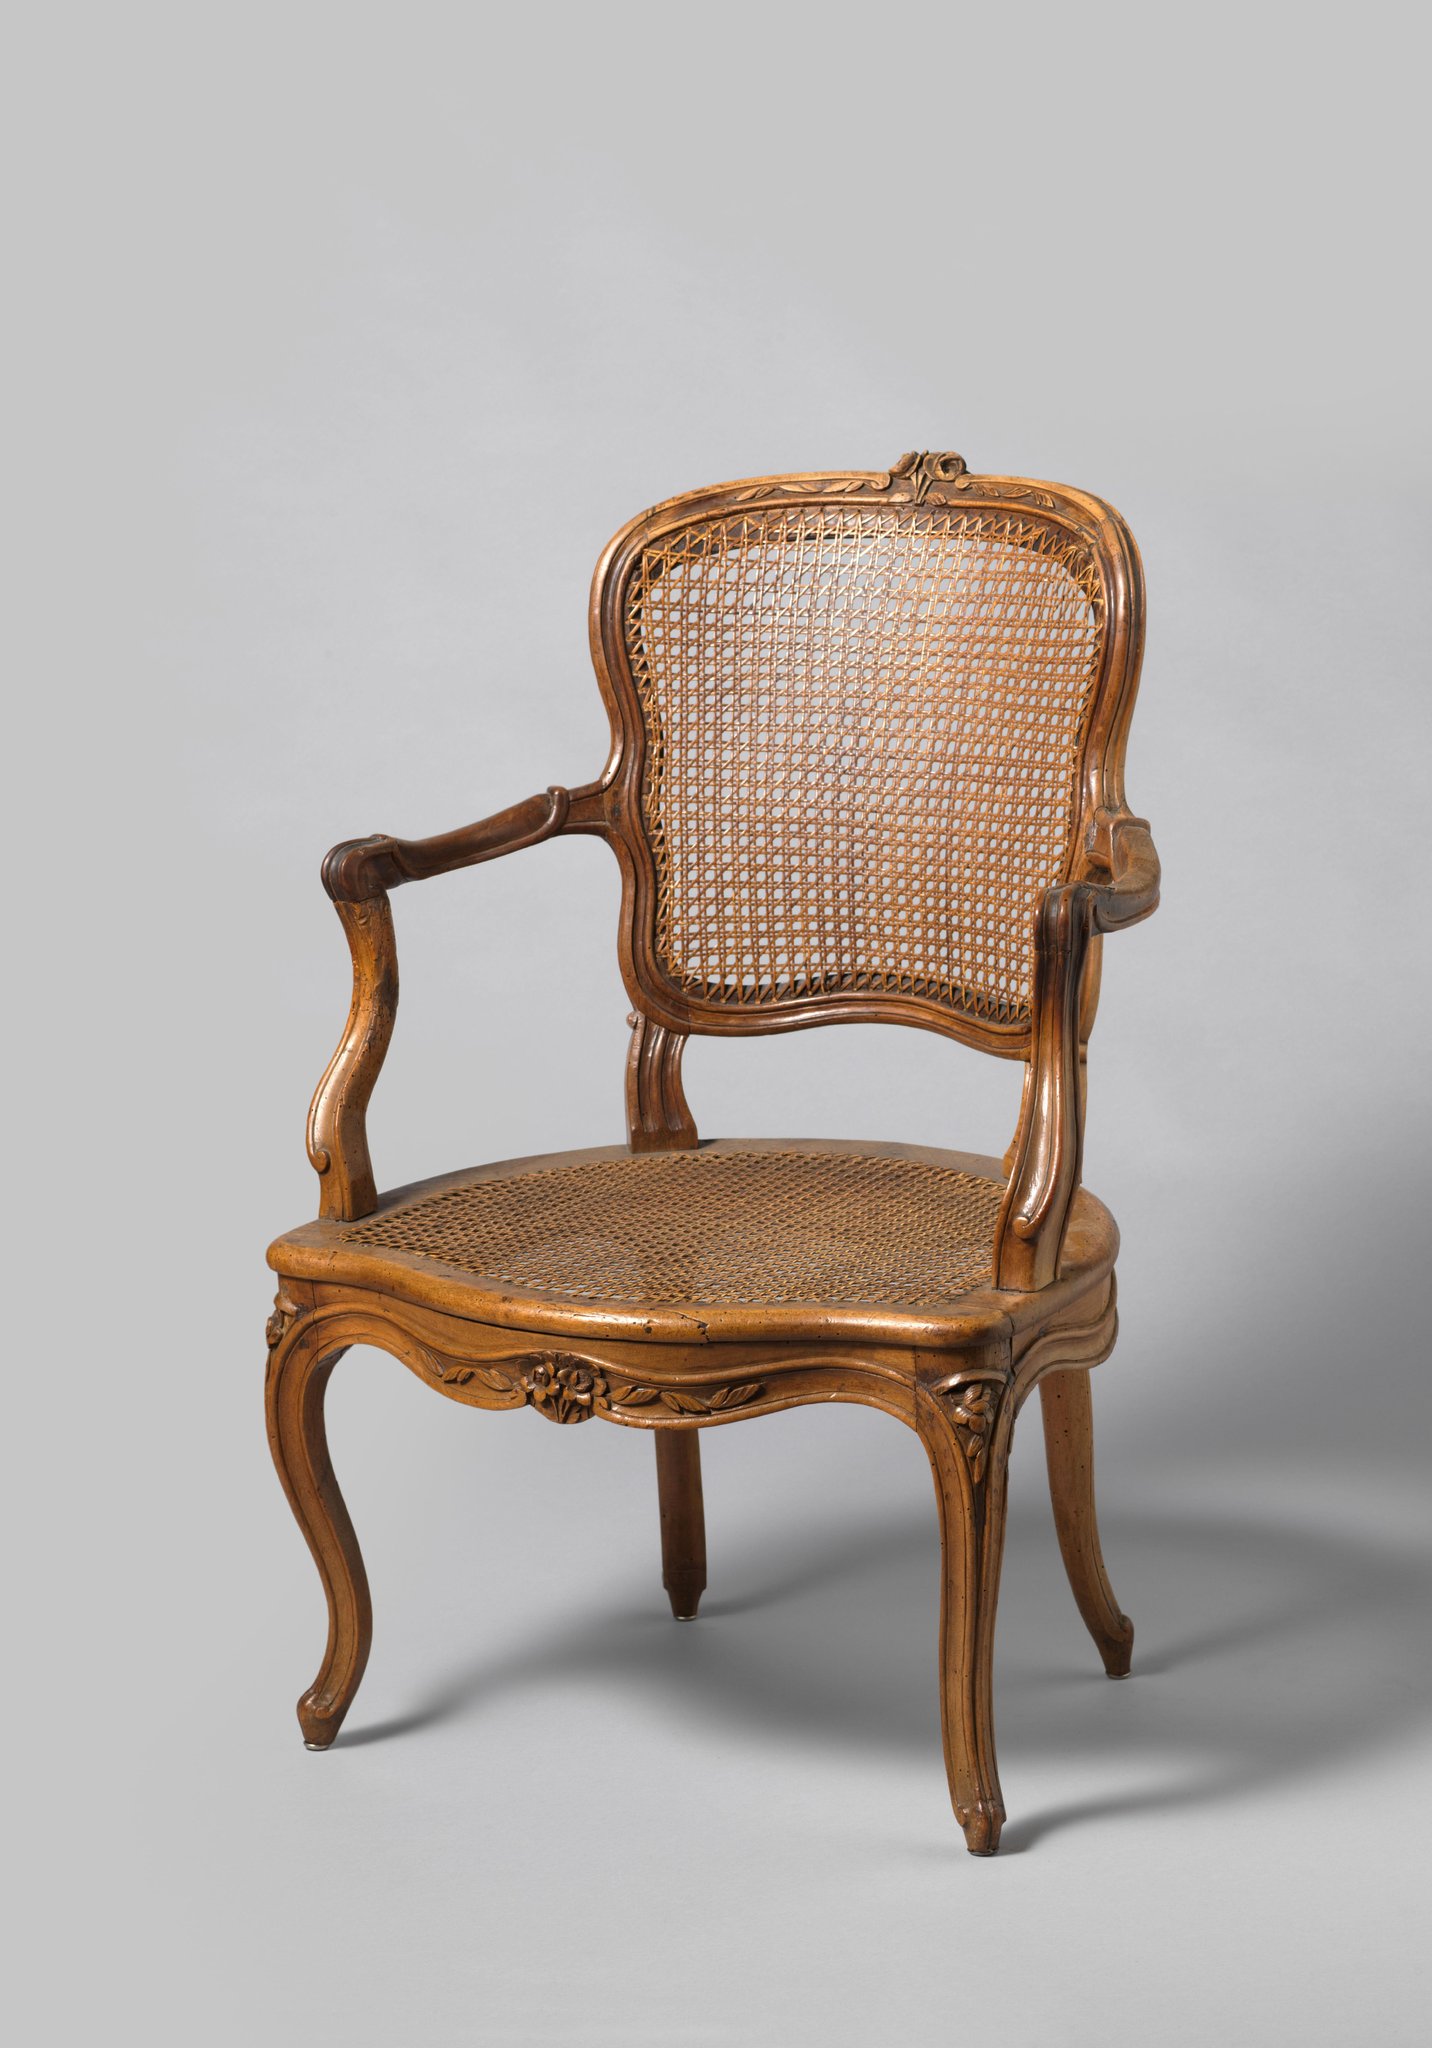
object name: seating furniture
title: Armstoel van notenhout met S-vormige overhoeks geplaatste poten met snijwerk van bloemen en bladeren. Rug en zitting van gevlochten riet. Met los kussen.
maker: Anonymous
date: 1750-1775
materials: wood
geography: france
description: Armstoel van notenhout (ameublement) met rug en zitting van gevlochten riet. De gestrekt S-vormige overhoeks geplaatste poten met profilering gaan zonder onderbreking in het zitraam over en zijn versierd met gestoken bloemen. Geschulpte voorregel met bloem- en bladwerk. Achterwaarts geplaatste armleggerstutten S-vormig; geholde armleggers eindigend in voluten. Bovenregel raam met gestoken voluten. Met los kussen. Zie ook: BK-16851-A t/m H.